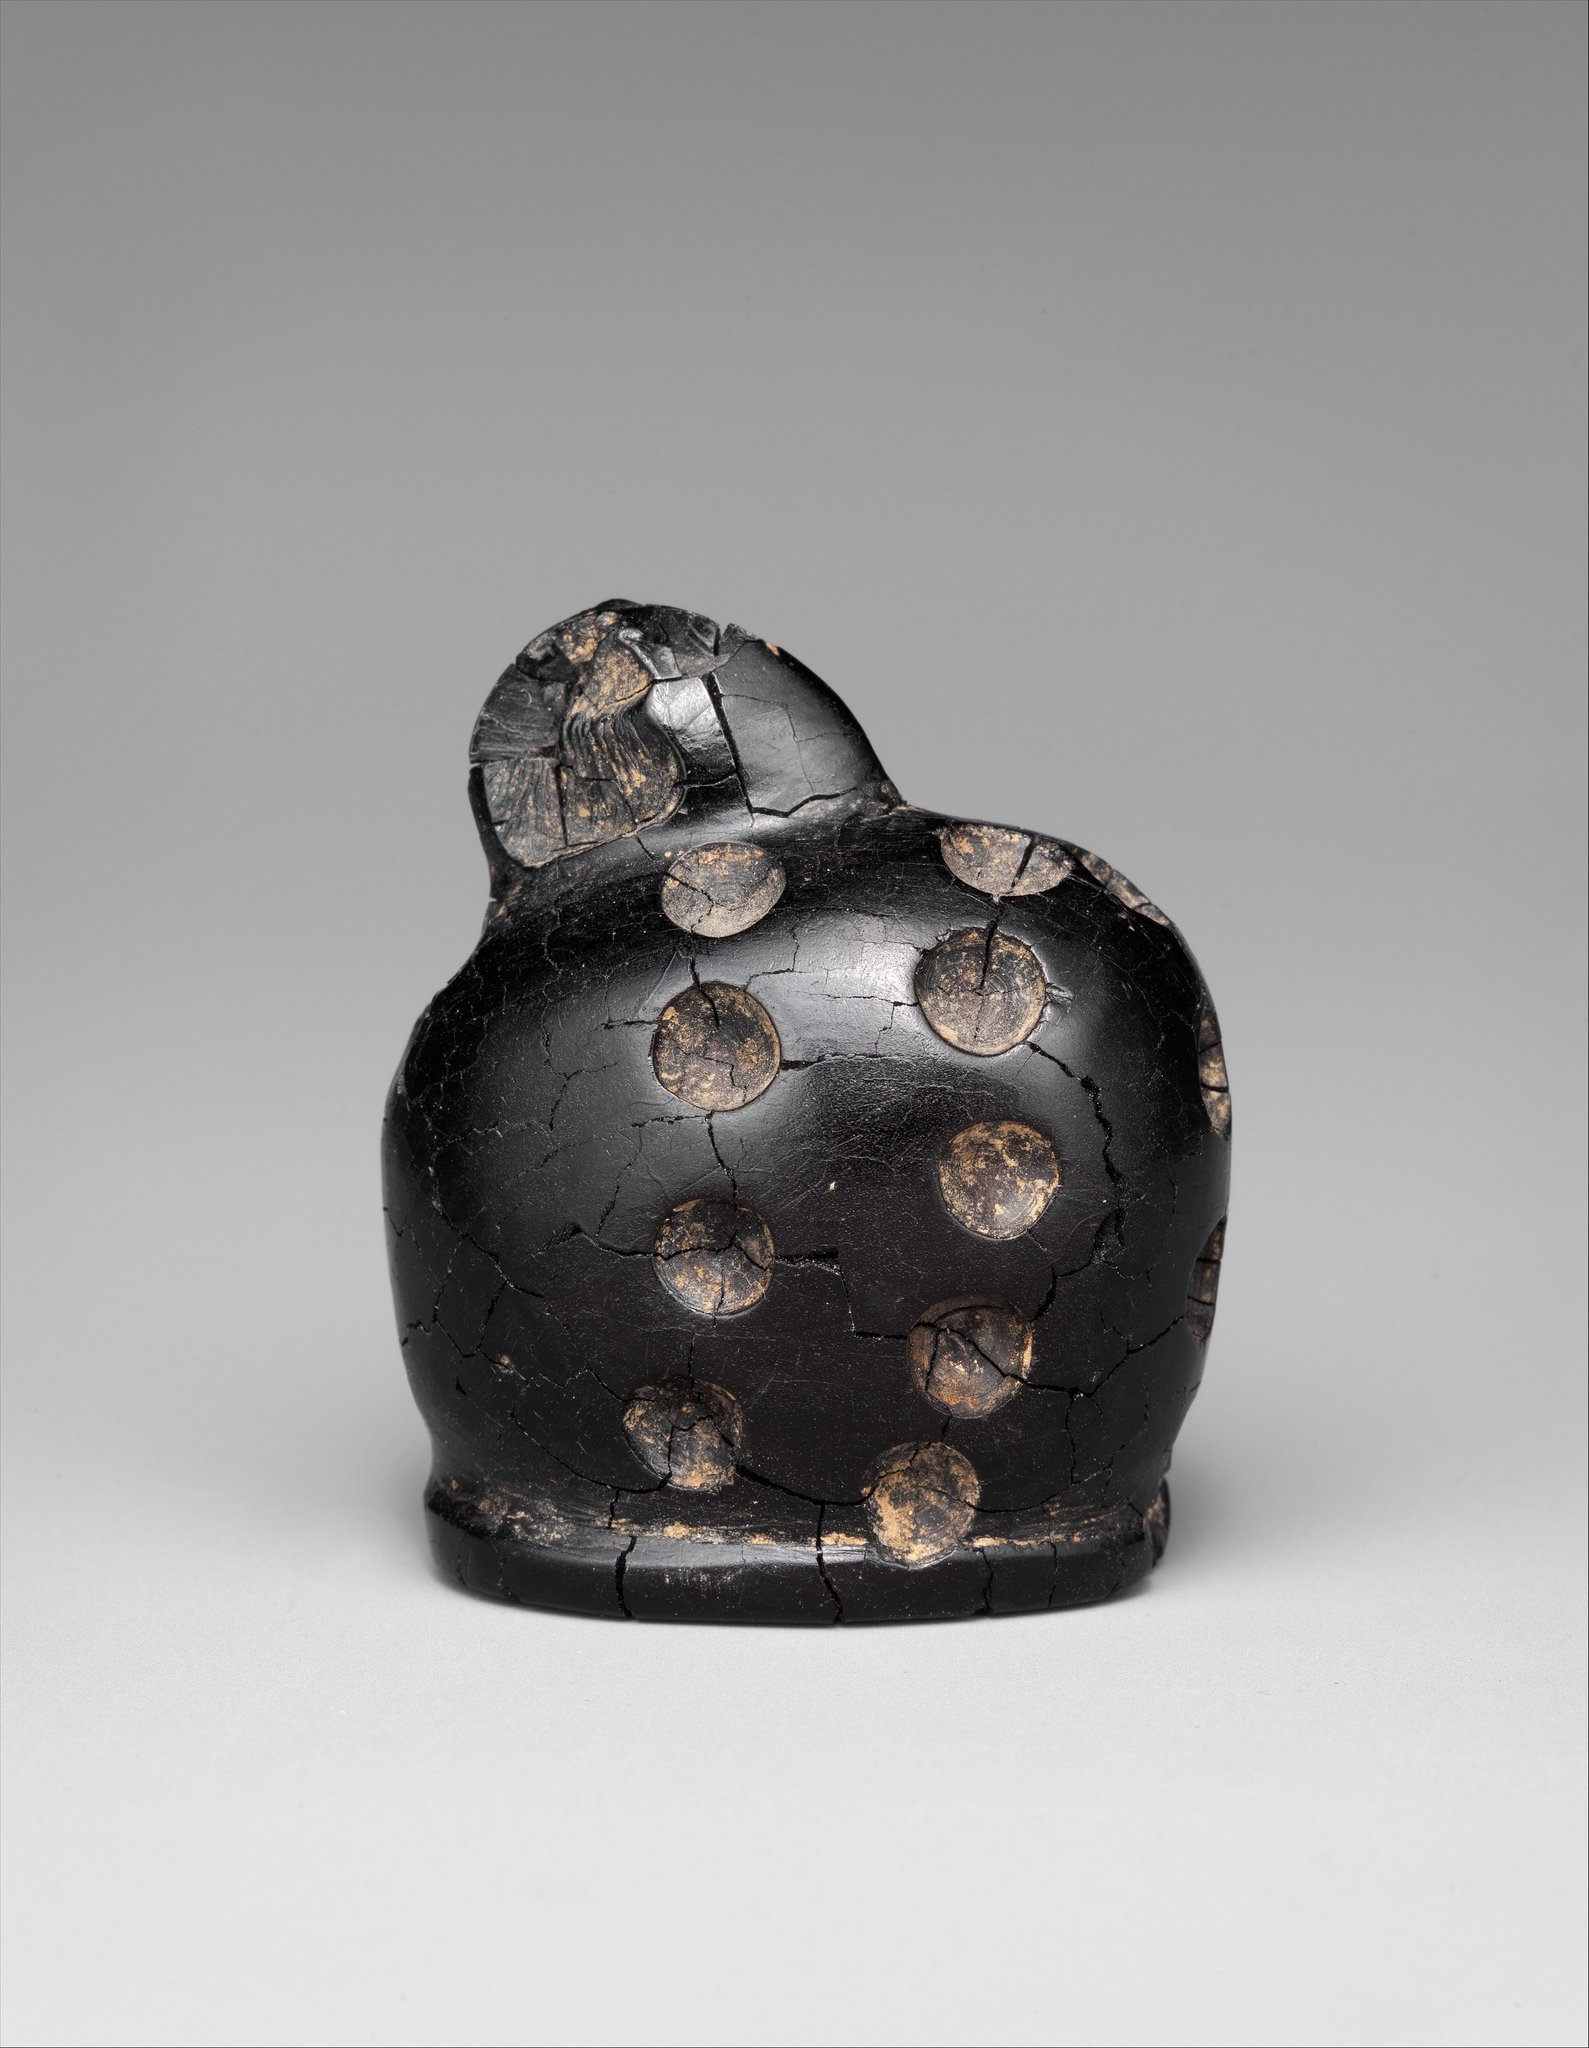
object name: chess piece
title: Chess Piece, Knight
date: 701-1000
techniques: carving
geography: iran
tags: chess